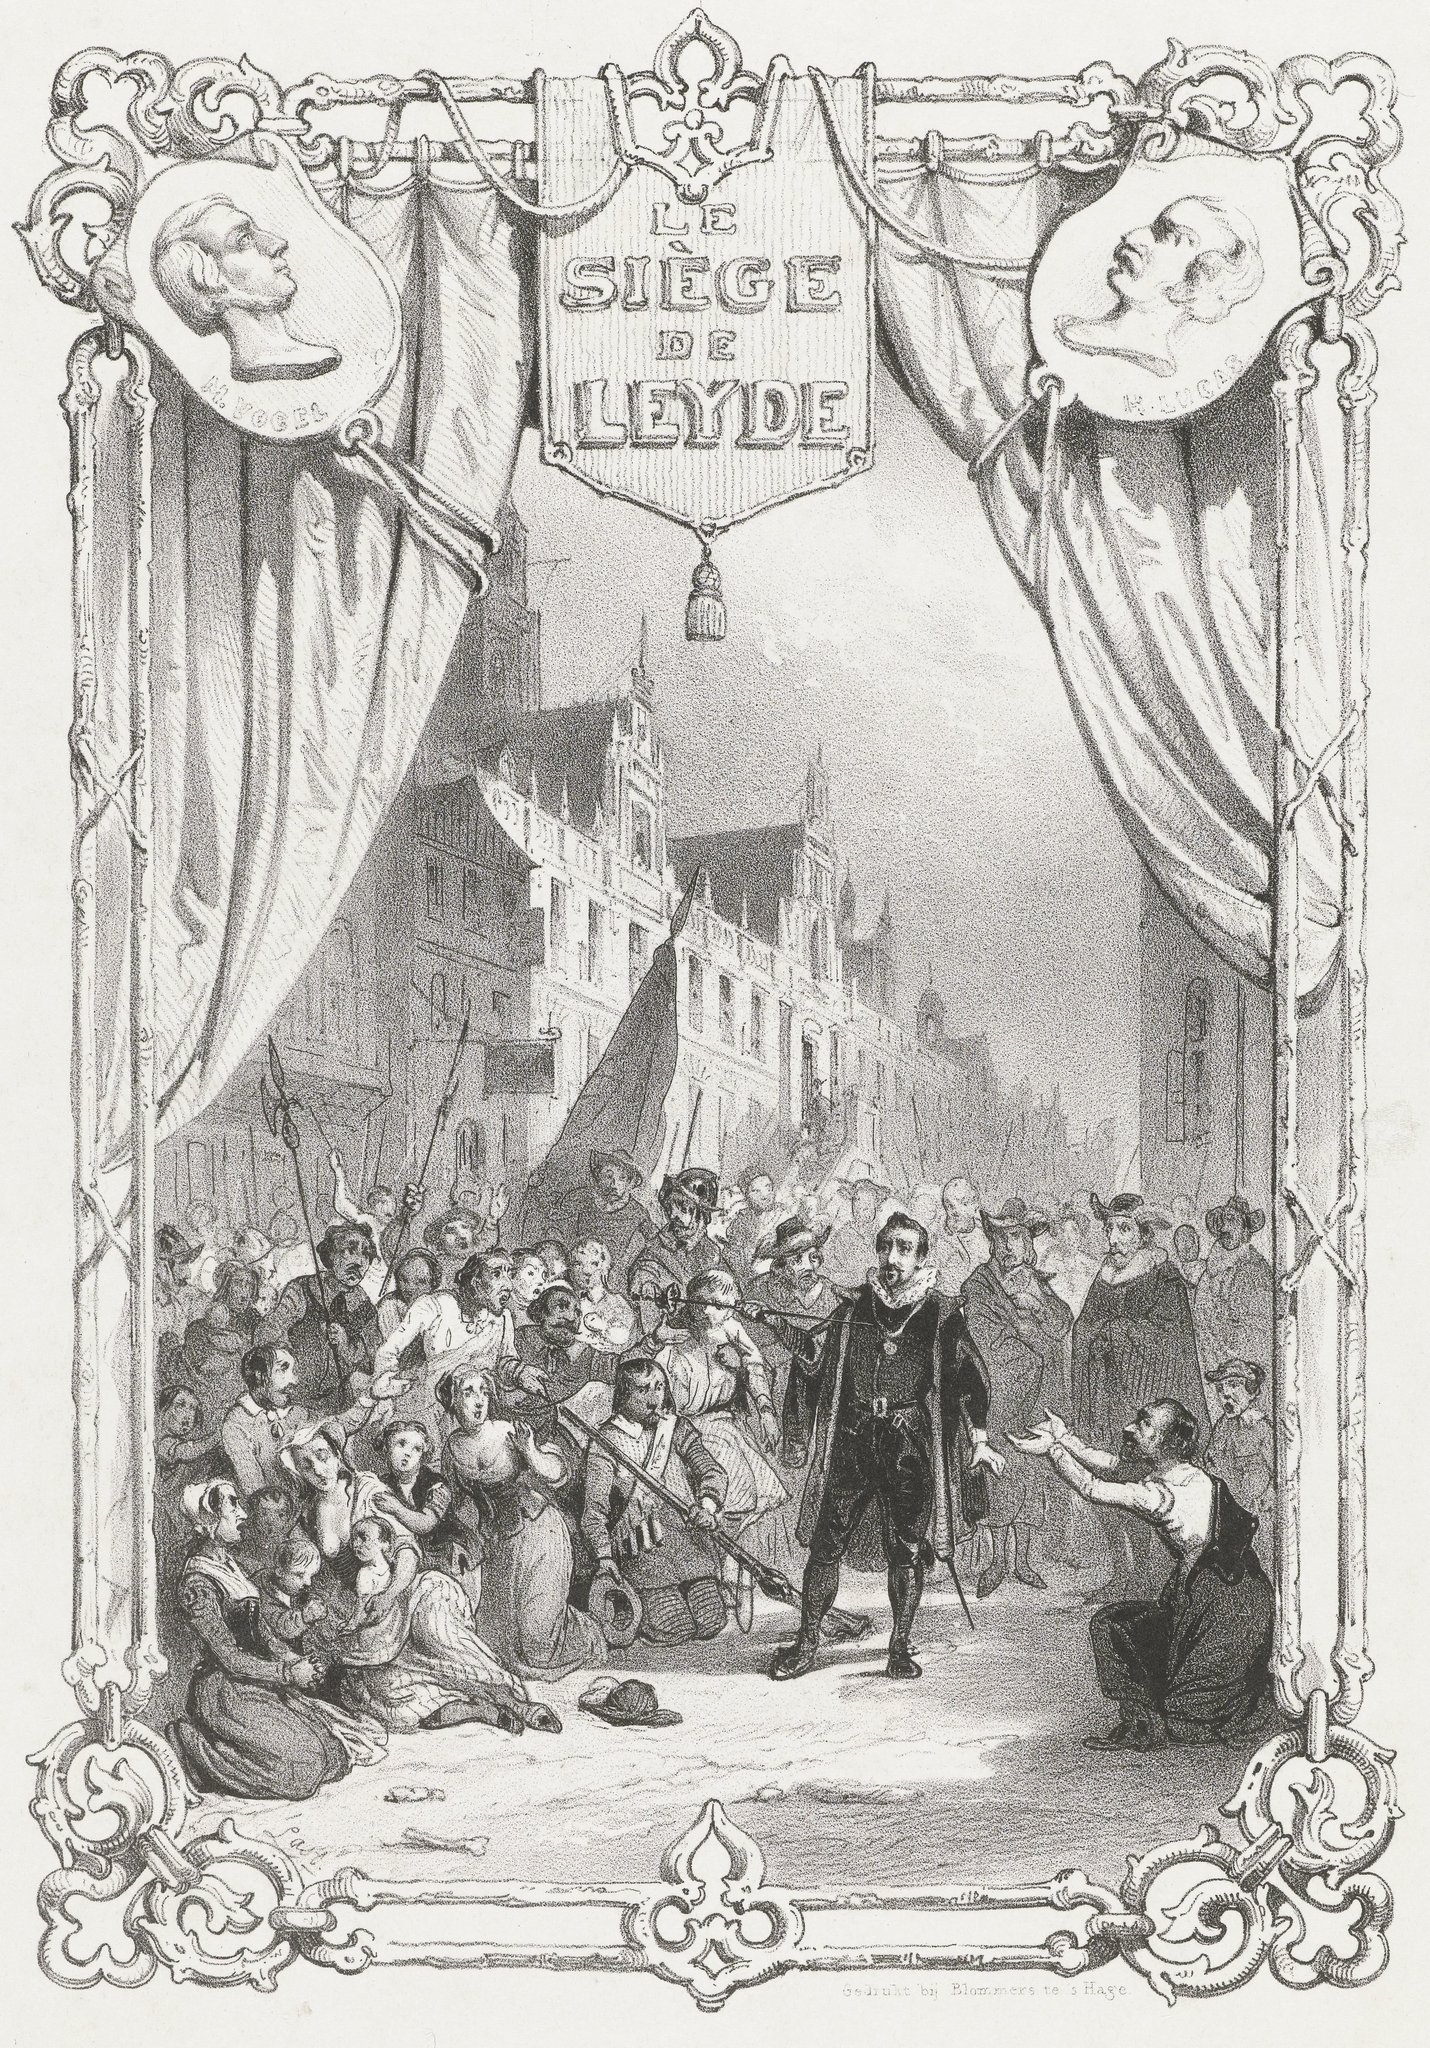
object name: print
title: De zelfopoffering van burgemeester Pieter van der Werff, 1574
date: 1845-1847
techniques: printmaking, lithograph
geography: netherlands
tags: mayor, group of actors, troupe; actors on the stage, leiden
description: Titelplaat voor de opera Le Siège de Leyde: de zelfopoffering van burgemeester Pieter van der Werff, tijdens het beleg van Leiden, 1574. Scène op een toneel in omlijsting met gordijnen en portretten van componist M. Vogel en librettist H. Lucas.